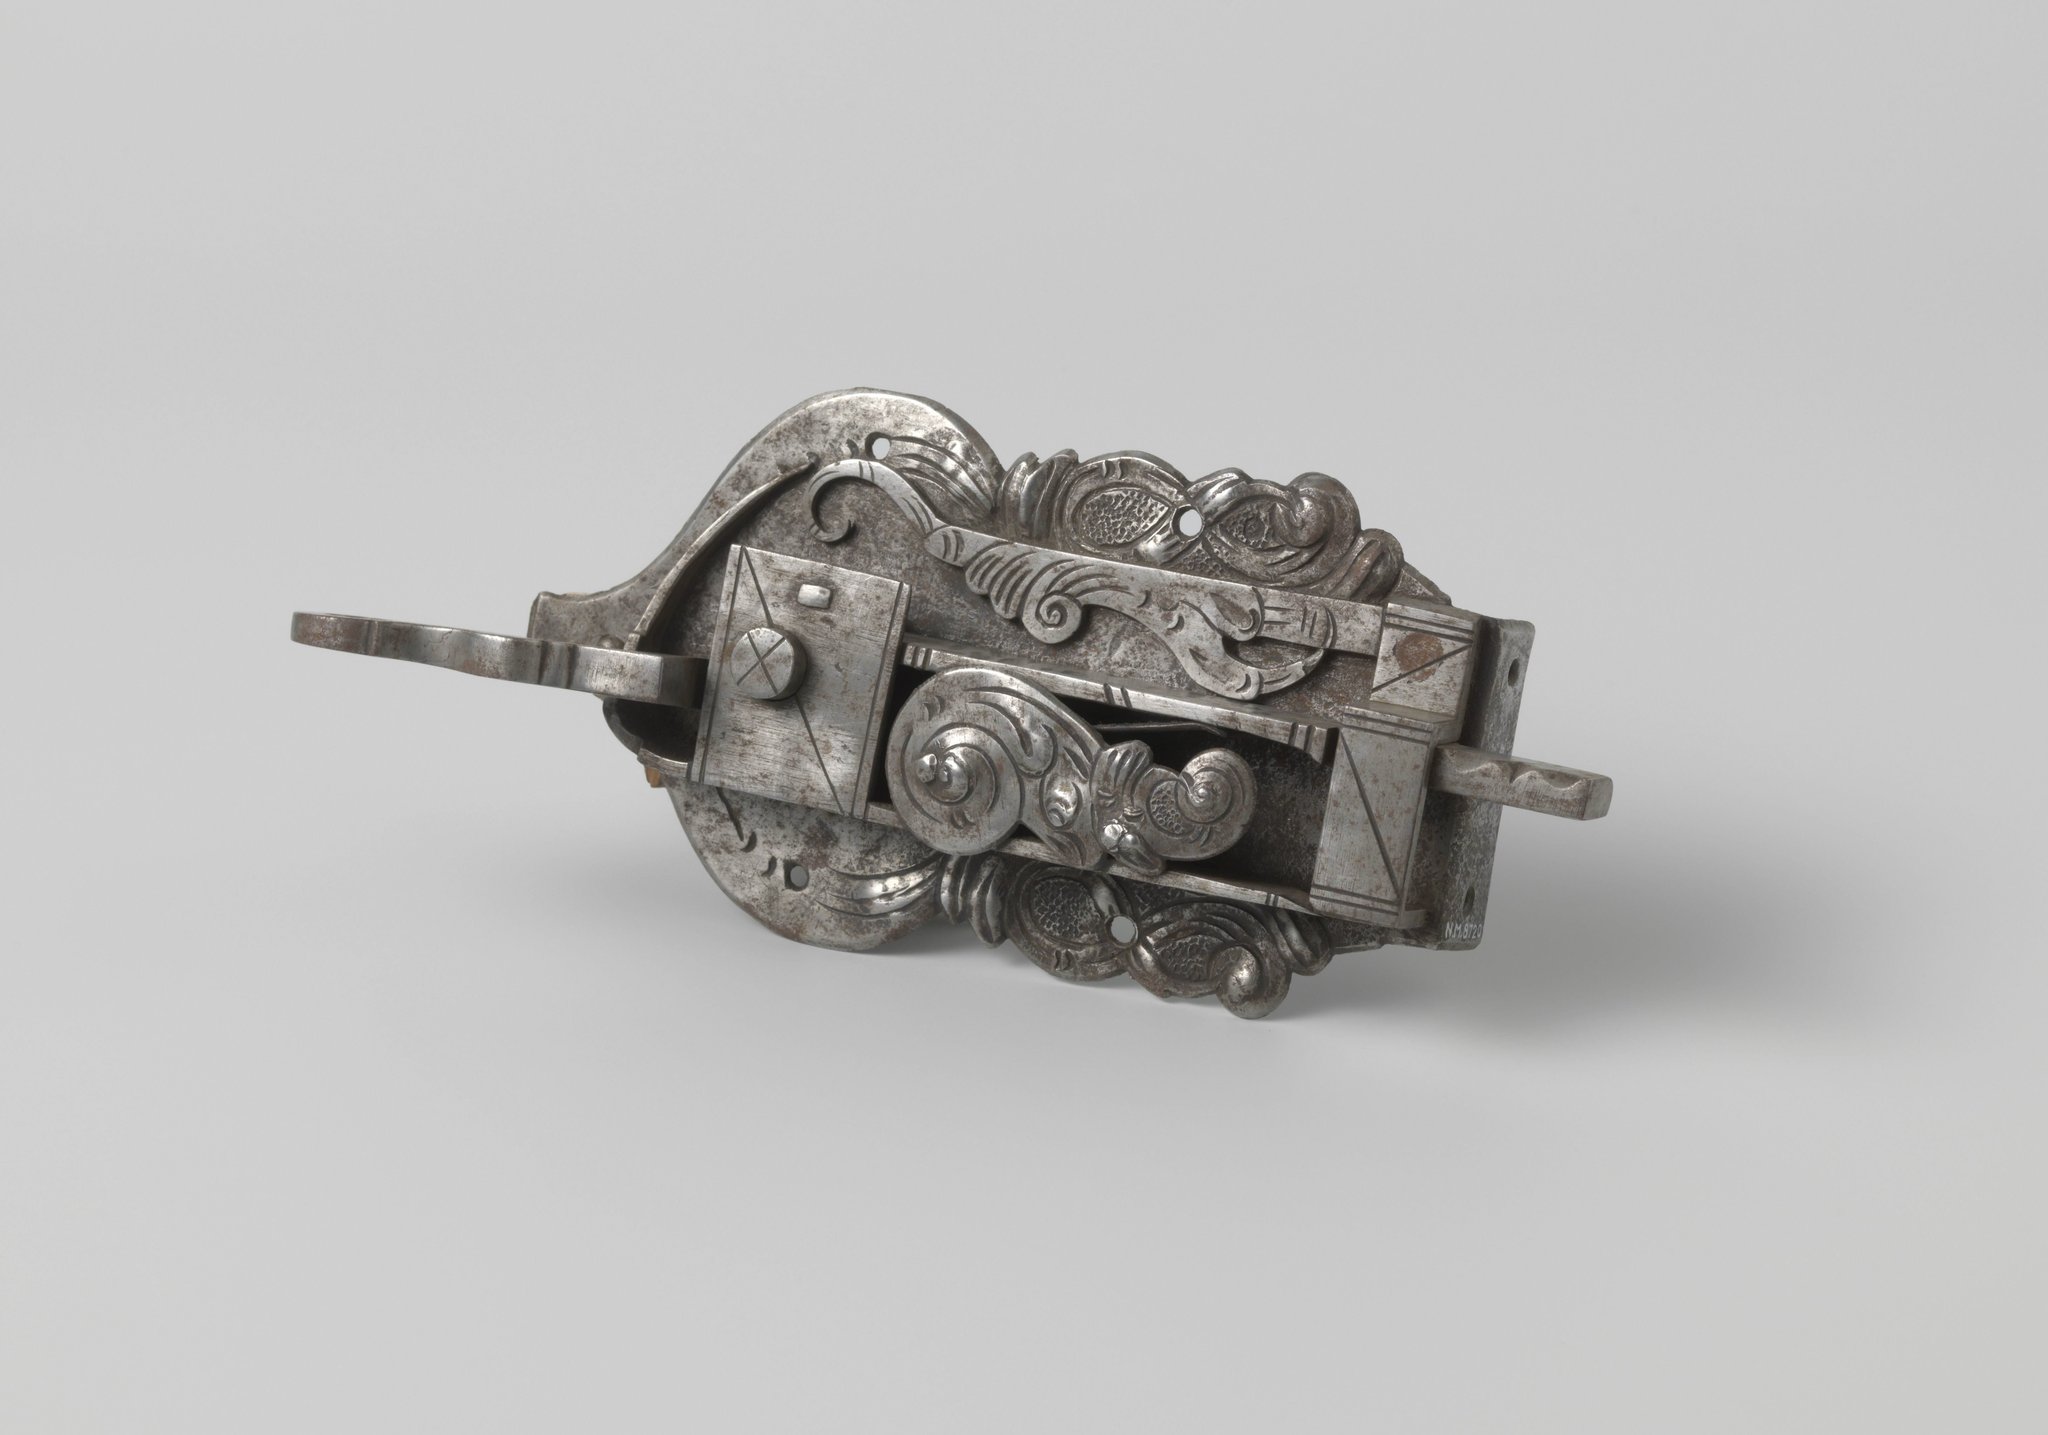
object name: lock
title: Knipslot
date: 1600-1699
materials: iron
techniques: engraving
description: Een knipslot, waarop gegraveerde bloemen.